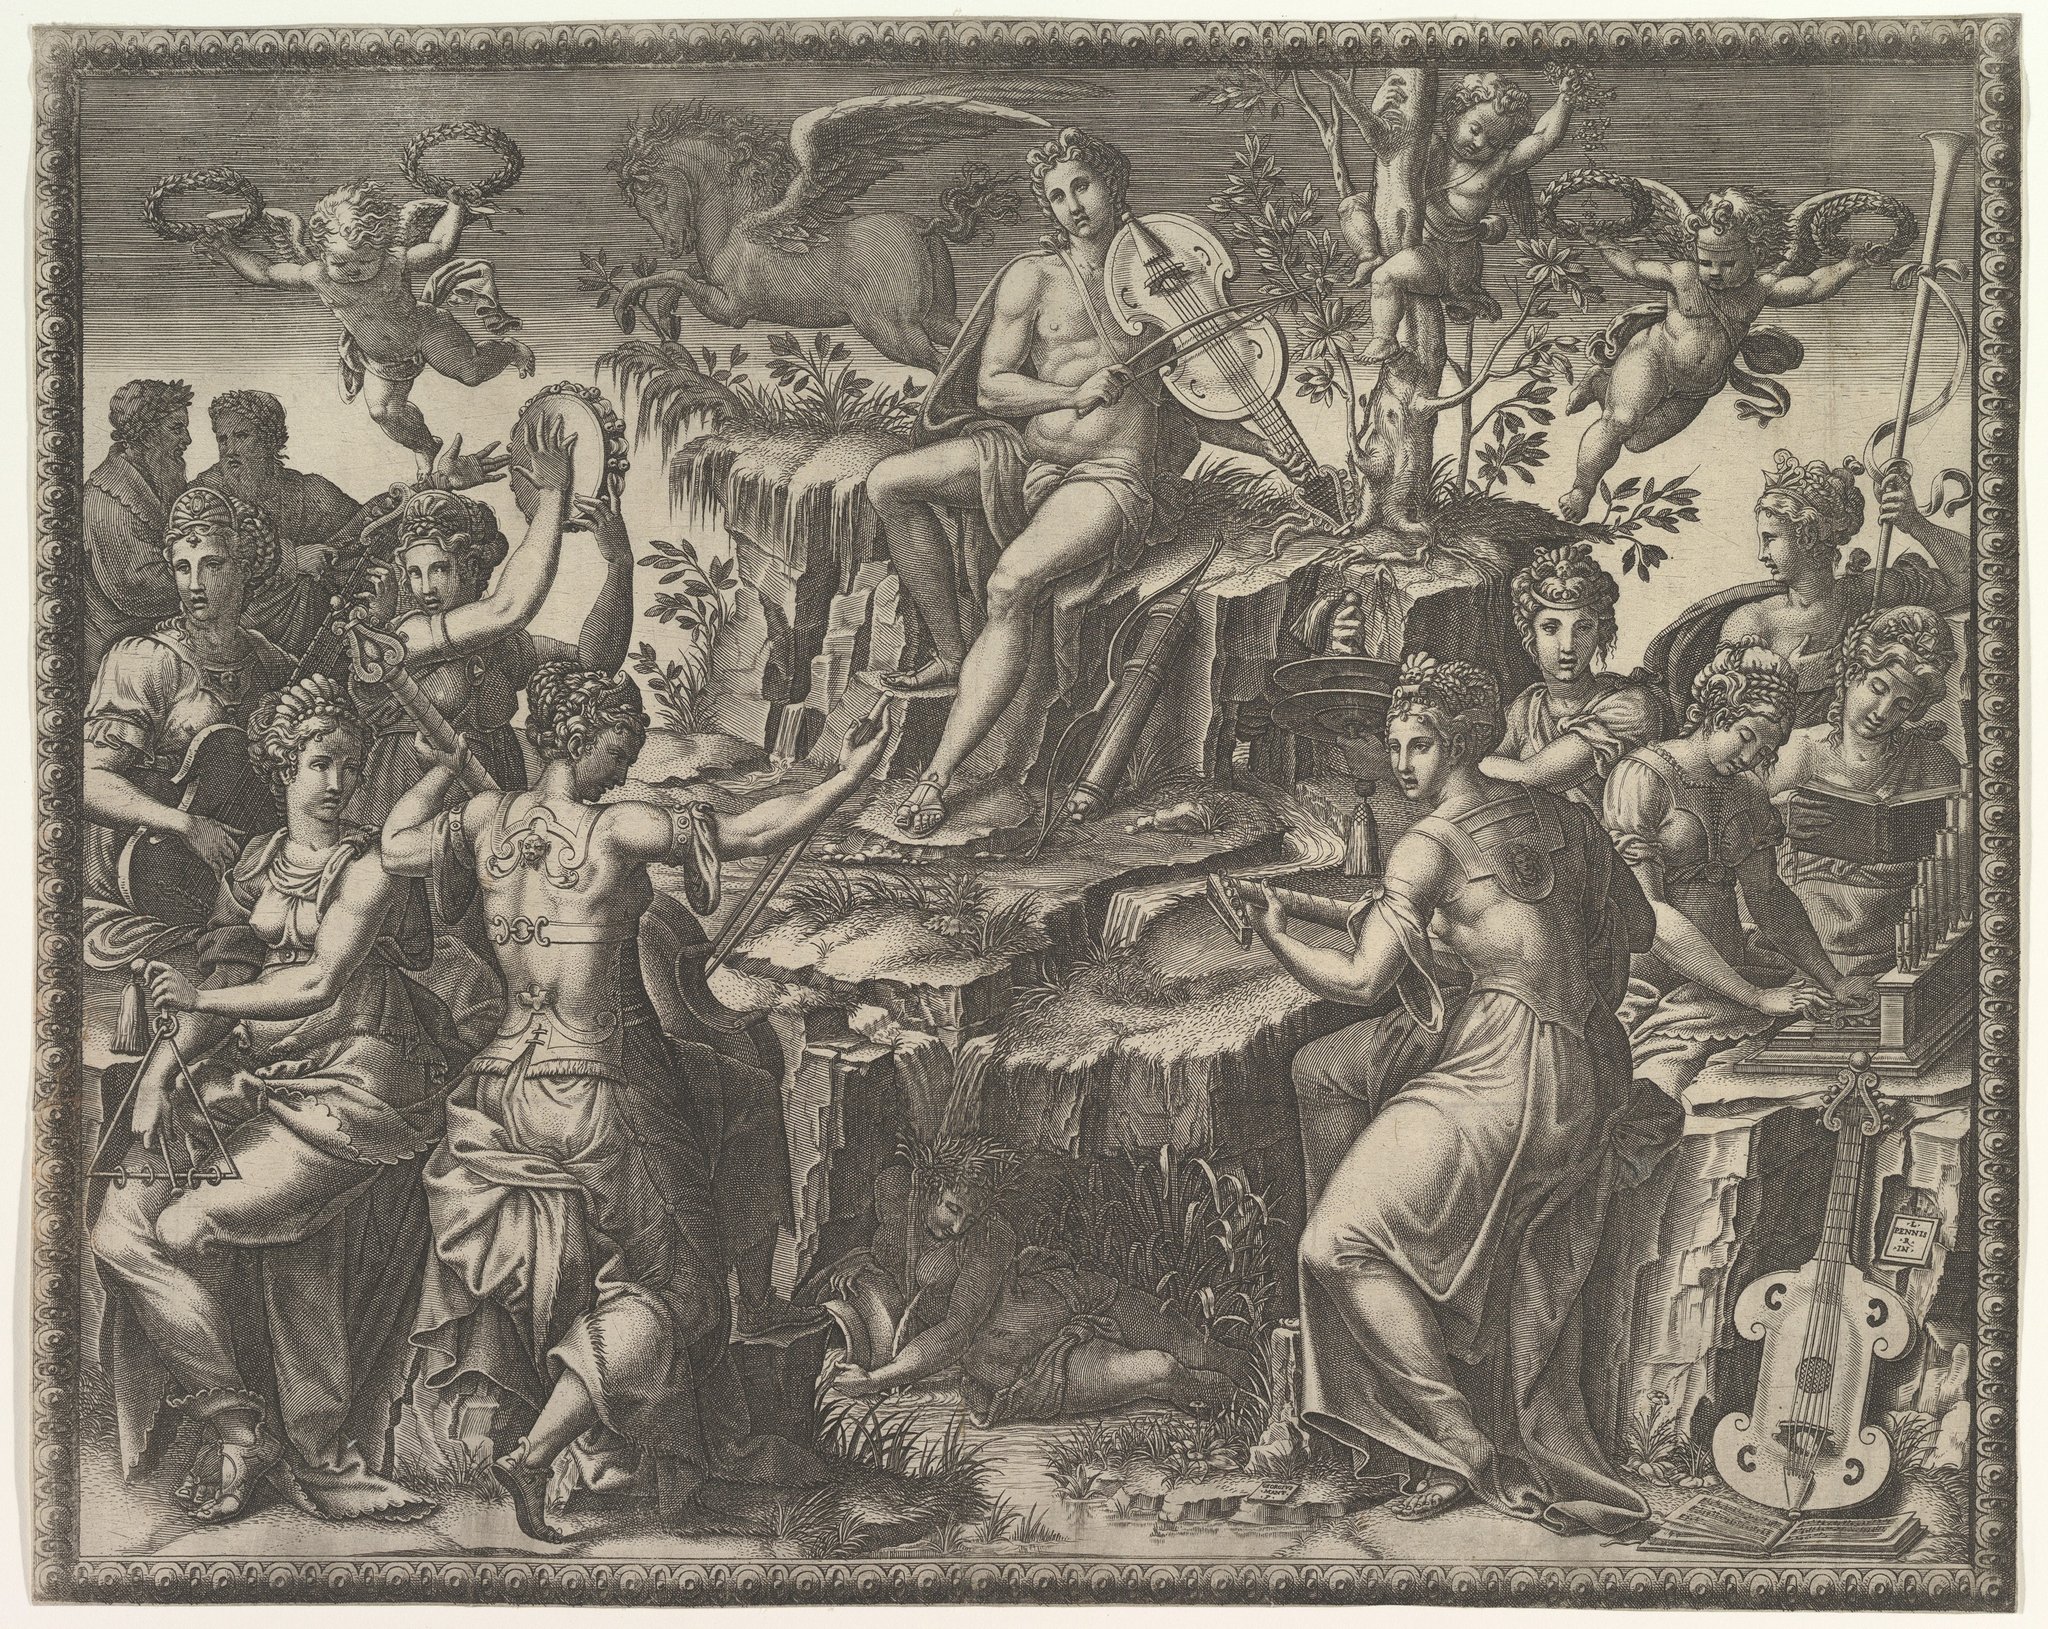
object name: print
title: Apollo and the Muses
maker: giorgio ghisi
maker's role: artist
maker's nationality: italian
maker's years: 1515-1582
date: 1557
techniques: engraving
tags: musical instruments,music,apollo,muses